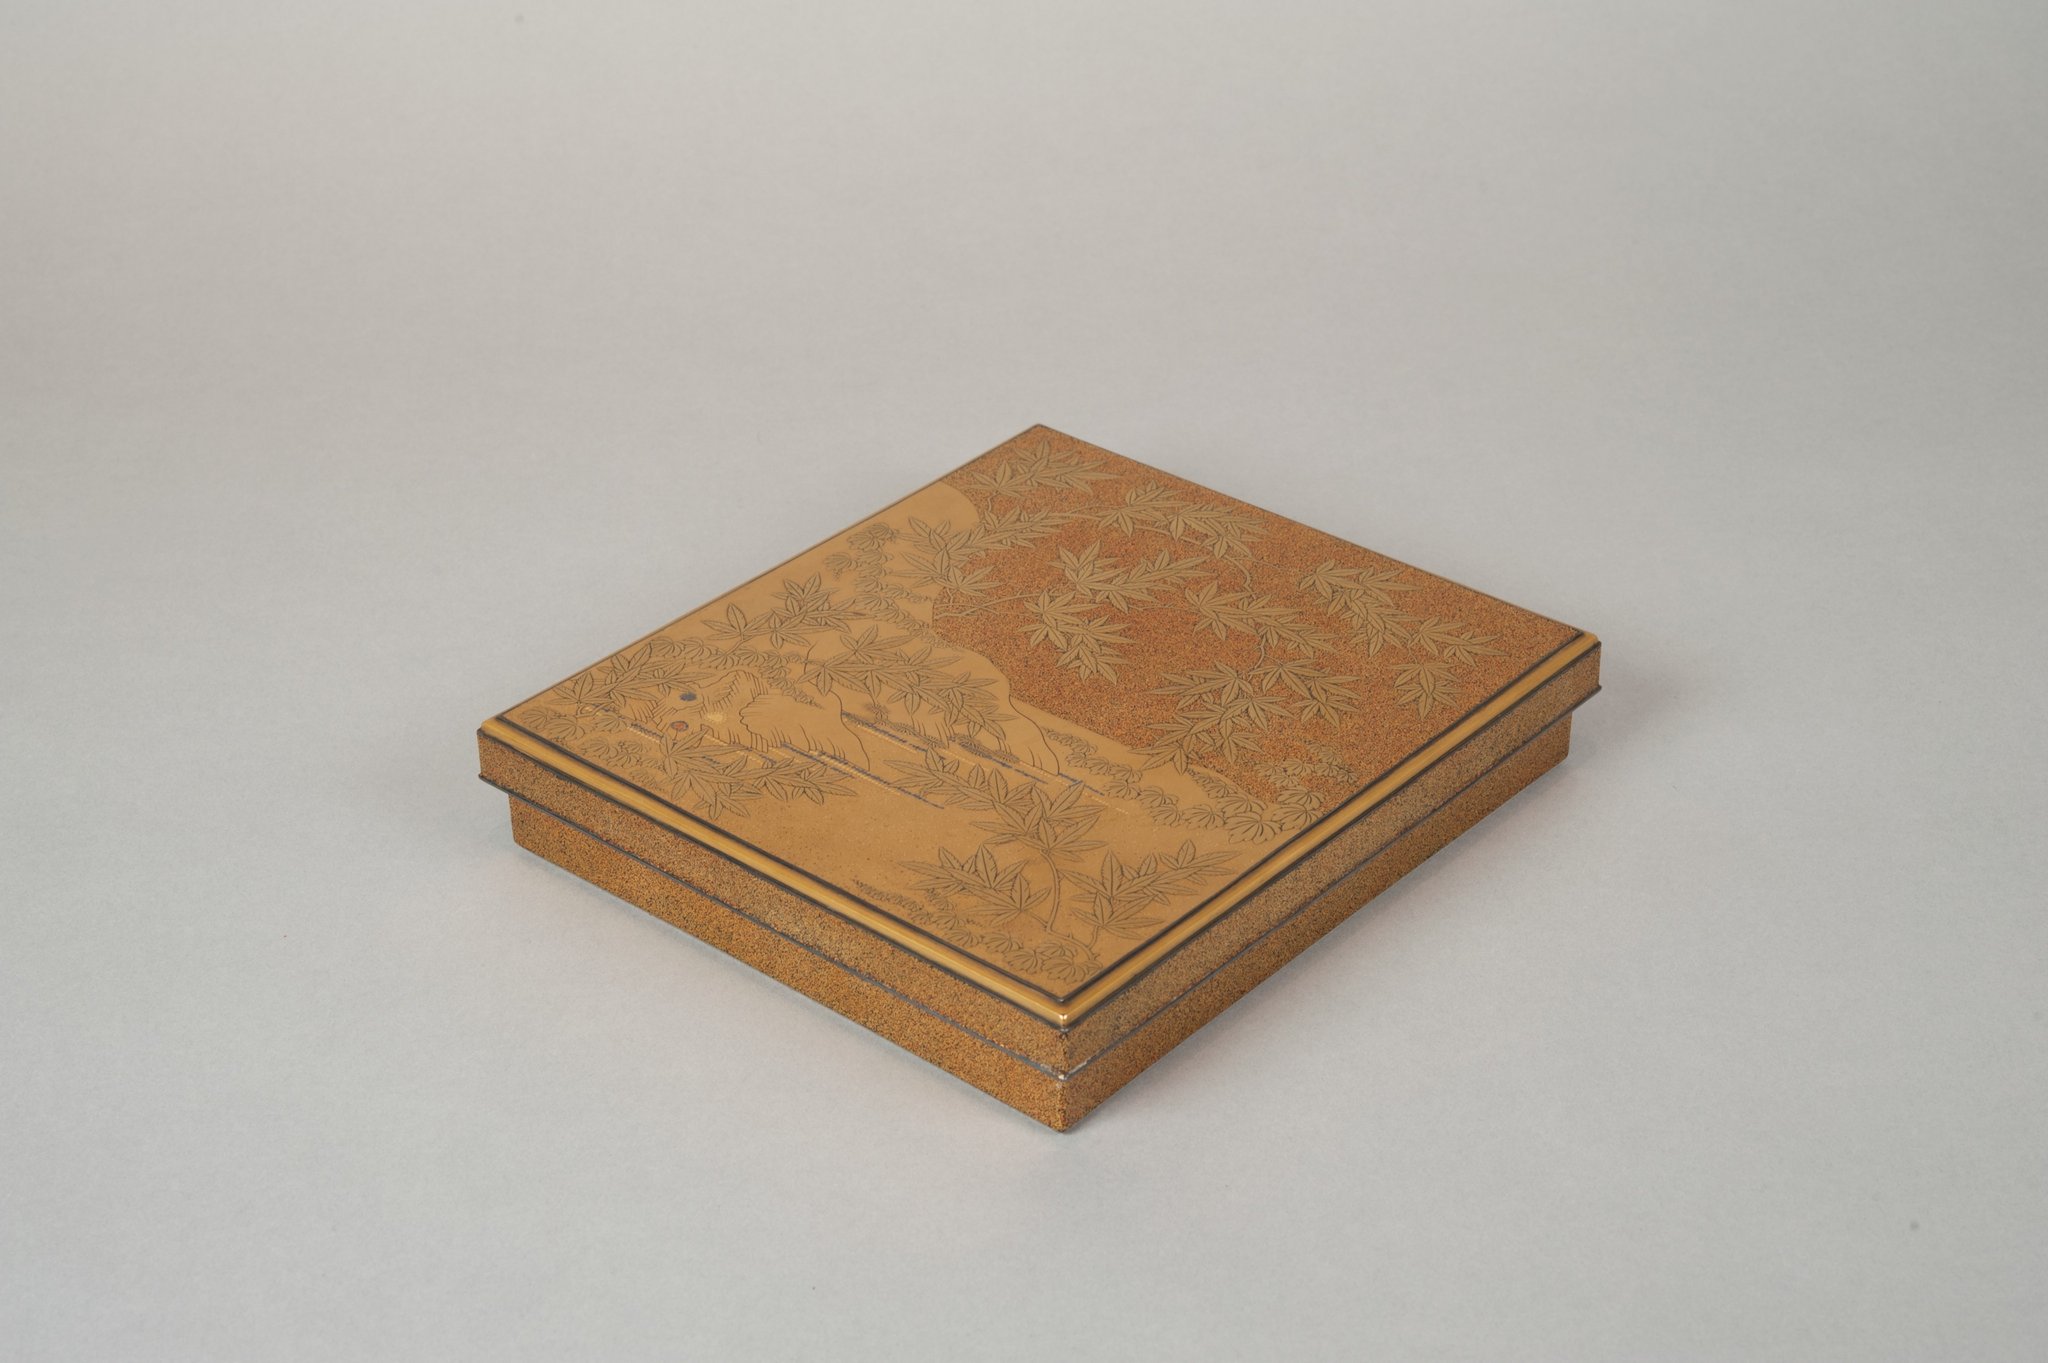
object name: writing box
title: Writing Box (Suzuribako) with Episodes from the Tales of Ise (Ise monogatari)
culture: japanese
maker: nakayama komin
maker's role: artist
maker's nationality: japanese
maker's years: 1808-1870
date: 1801-1900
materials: gold, lacquer, silver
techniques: inlay, maki